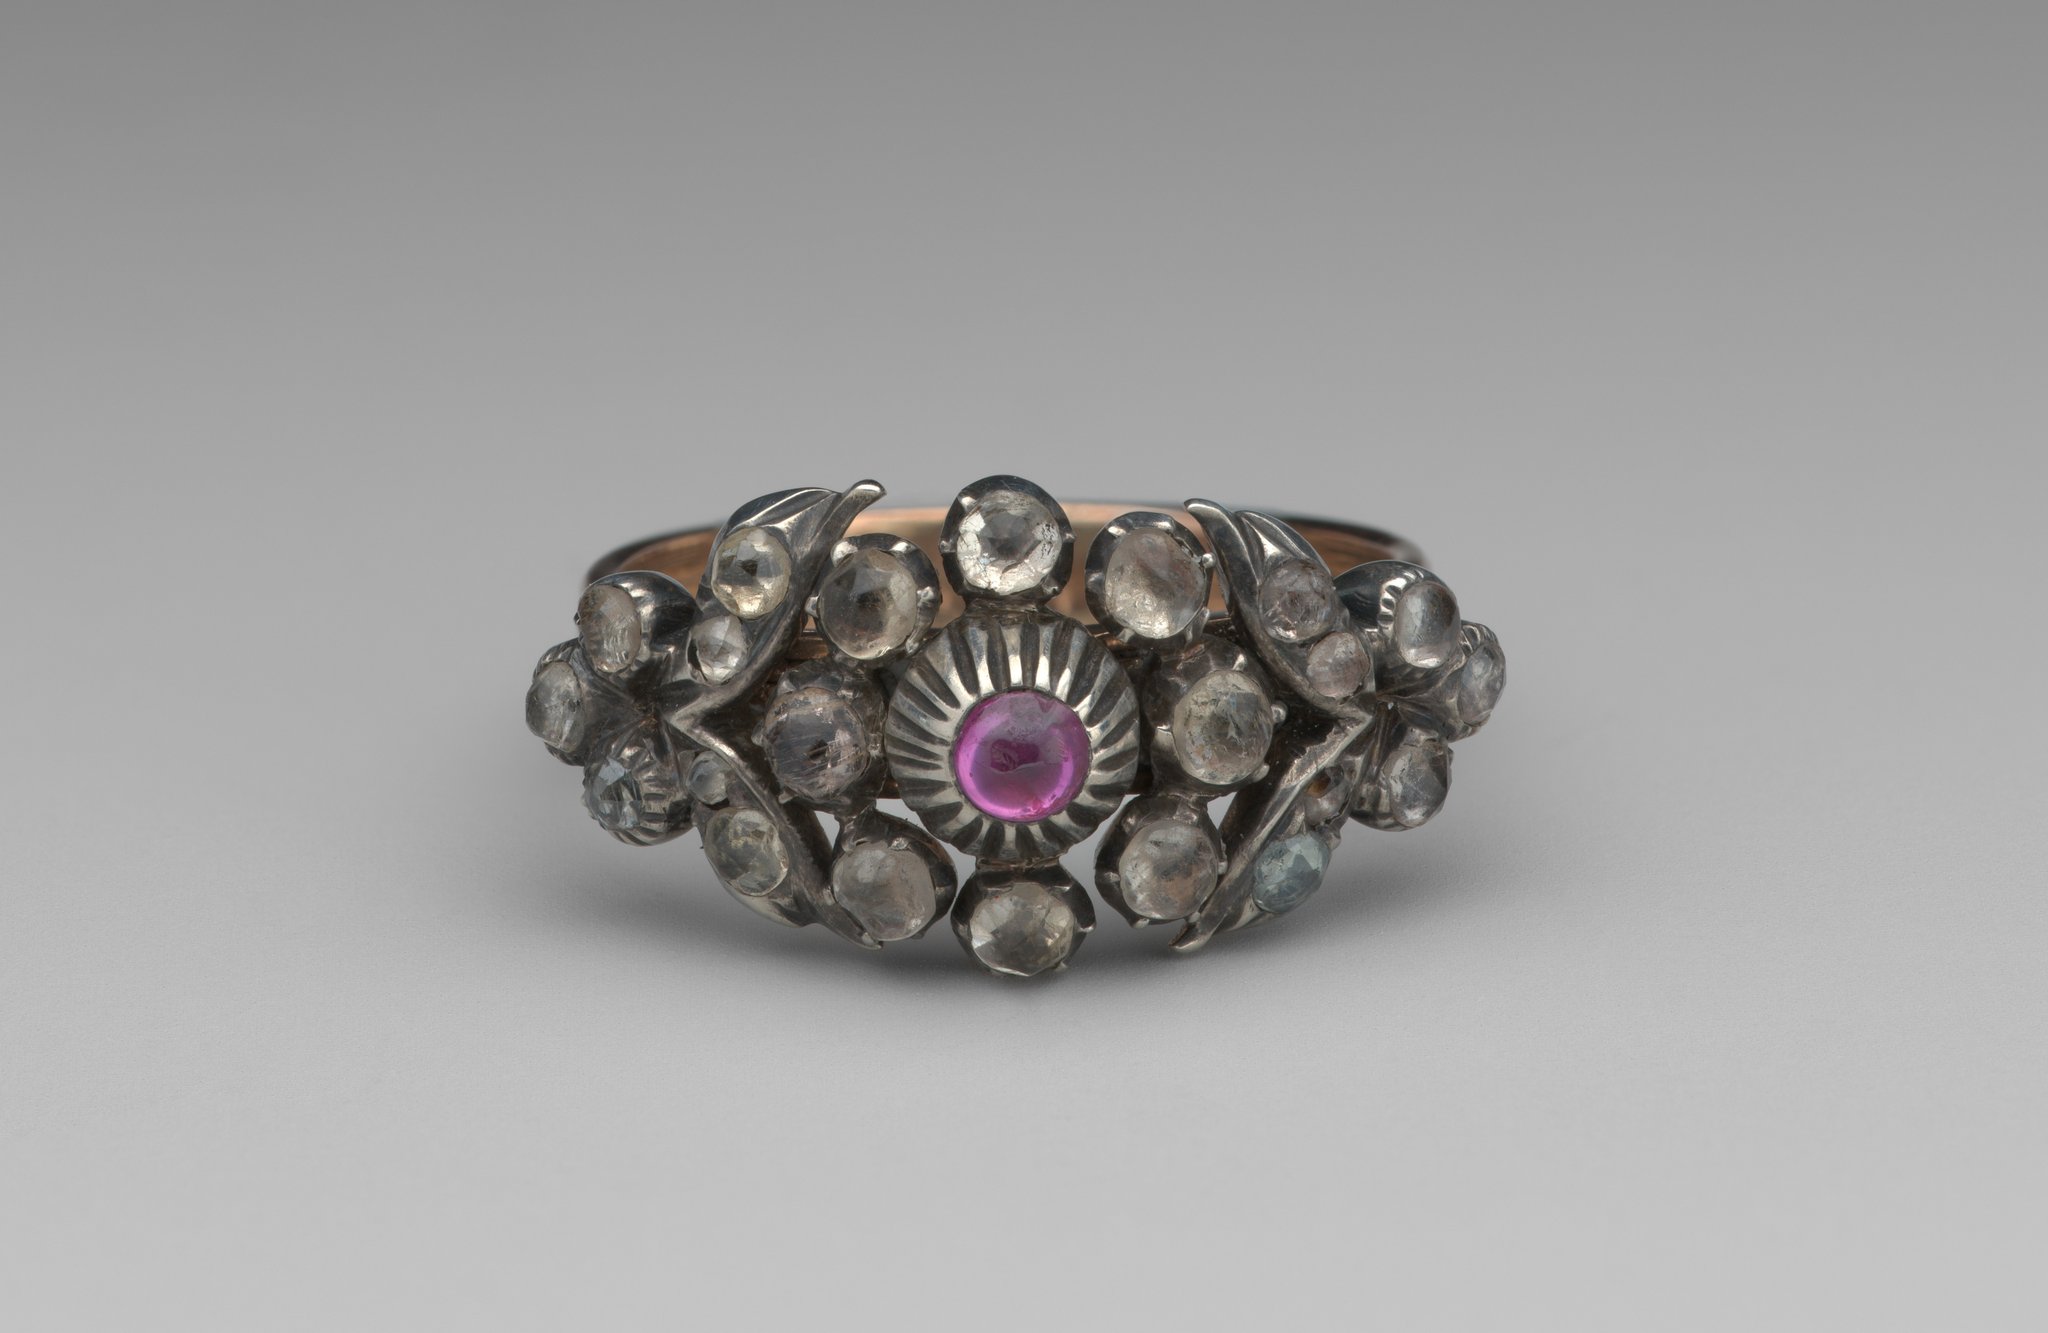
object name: ring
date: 1801-1900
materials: diamond, gold, gemstone, silver